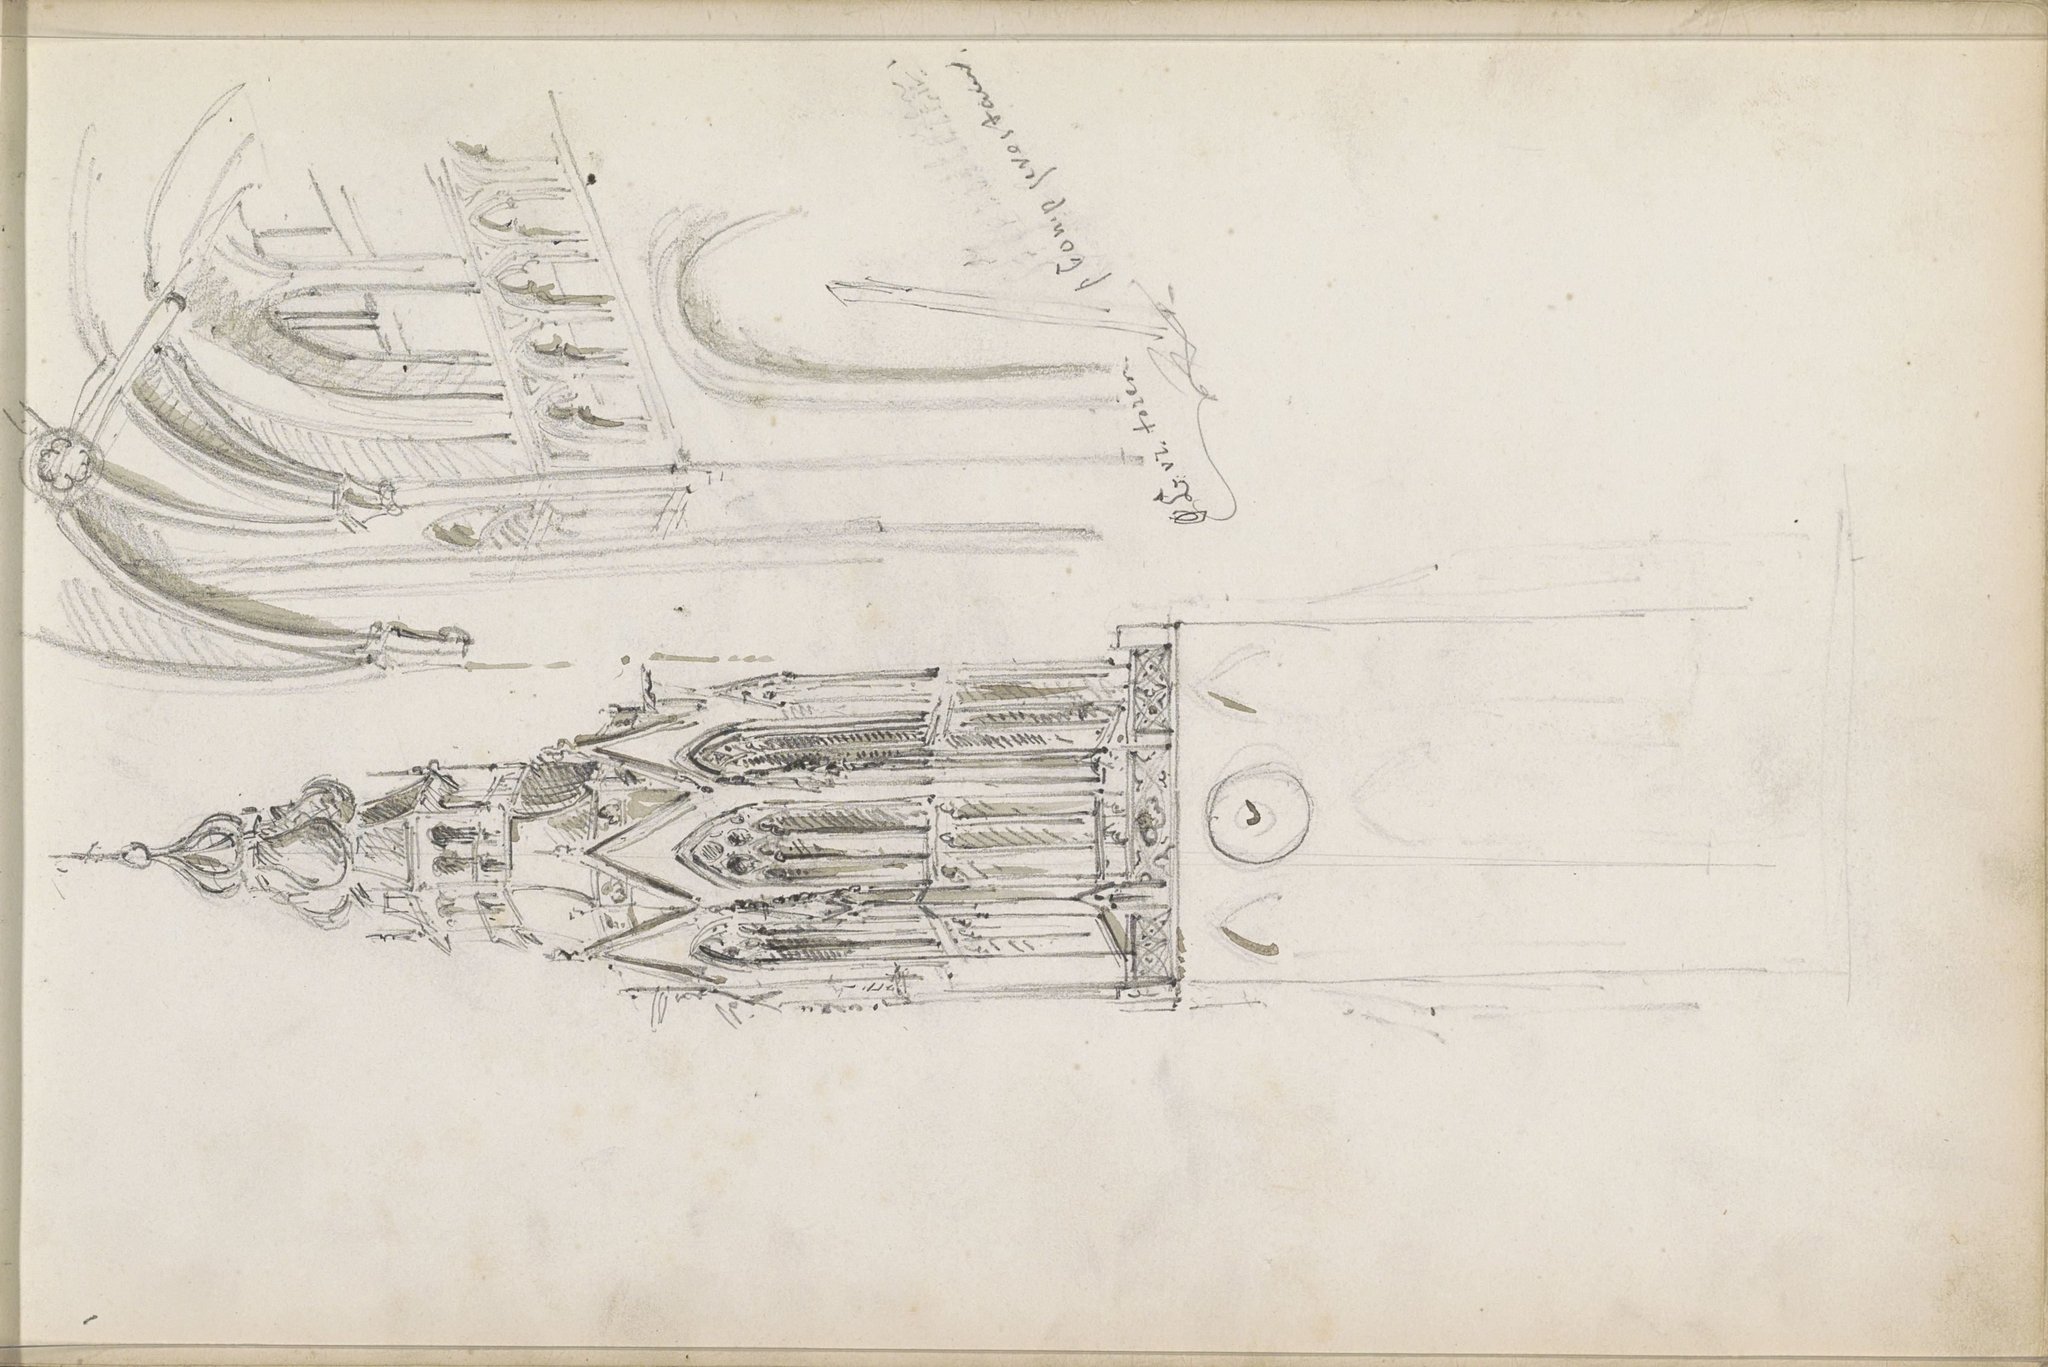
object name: sketchbook leaf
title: Onze-Lieve-Vrouwetoren te Amersfoort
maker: isaac gosschalk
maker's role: draughtsman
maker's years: 1838-1907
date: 1862-1867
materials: paper, pencil, watercolor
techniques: brush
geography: amersfoort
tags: parts of church exterior and annexes: façade, parts of church exterior and annexes: spire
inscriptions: annotation: ‘O.L. vr toren/ plomp geve[...]sta[...]’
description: Tevens een deel van de gevel van de kerk. Blad 18 recto uit een schetsboek met 58 bladen.